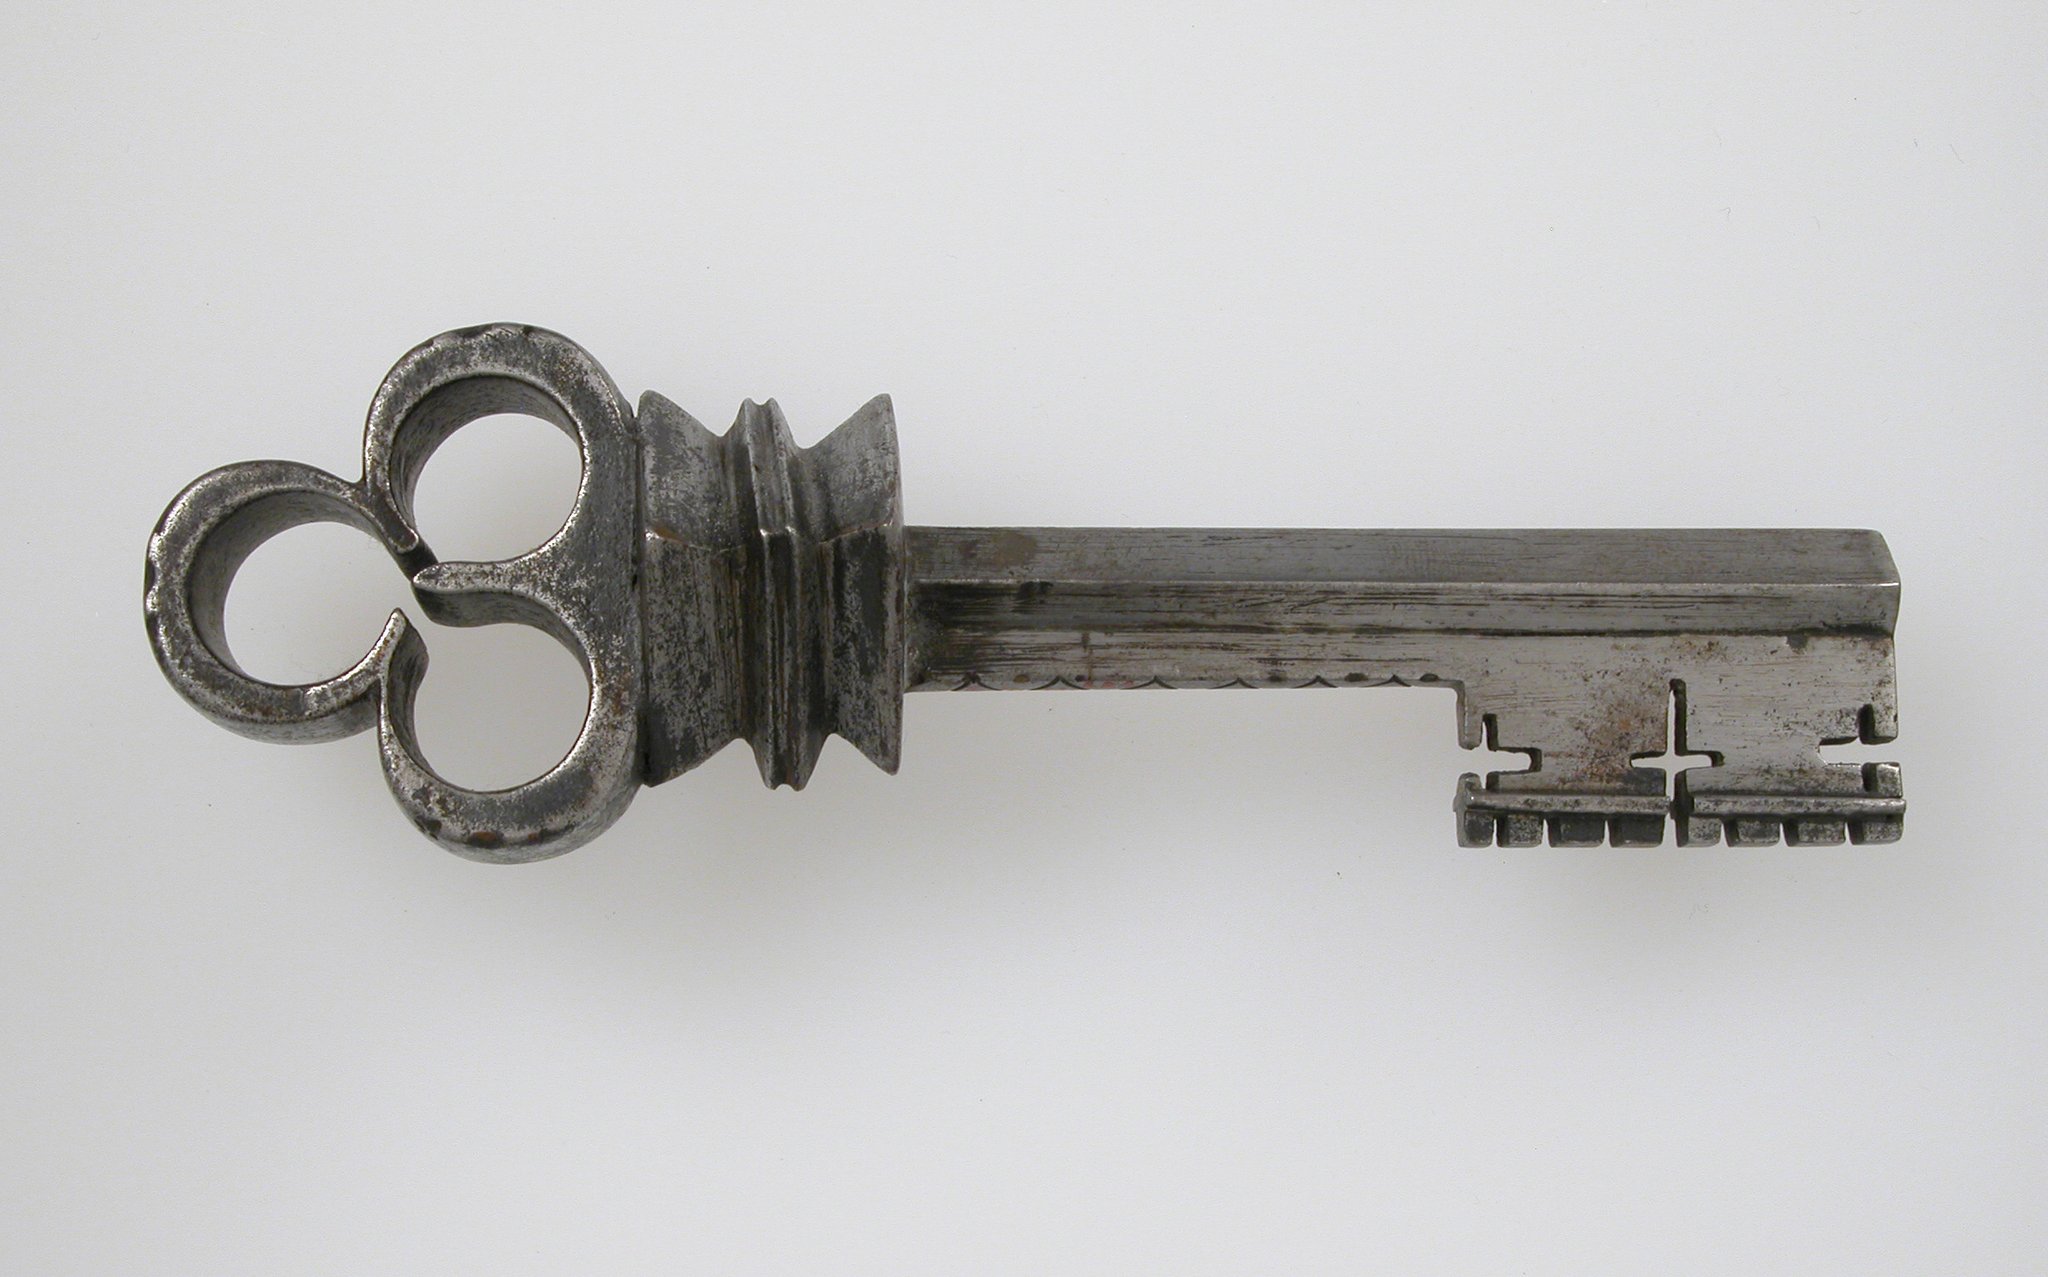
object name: key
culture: german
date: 1401-1500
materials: iron